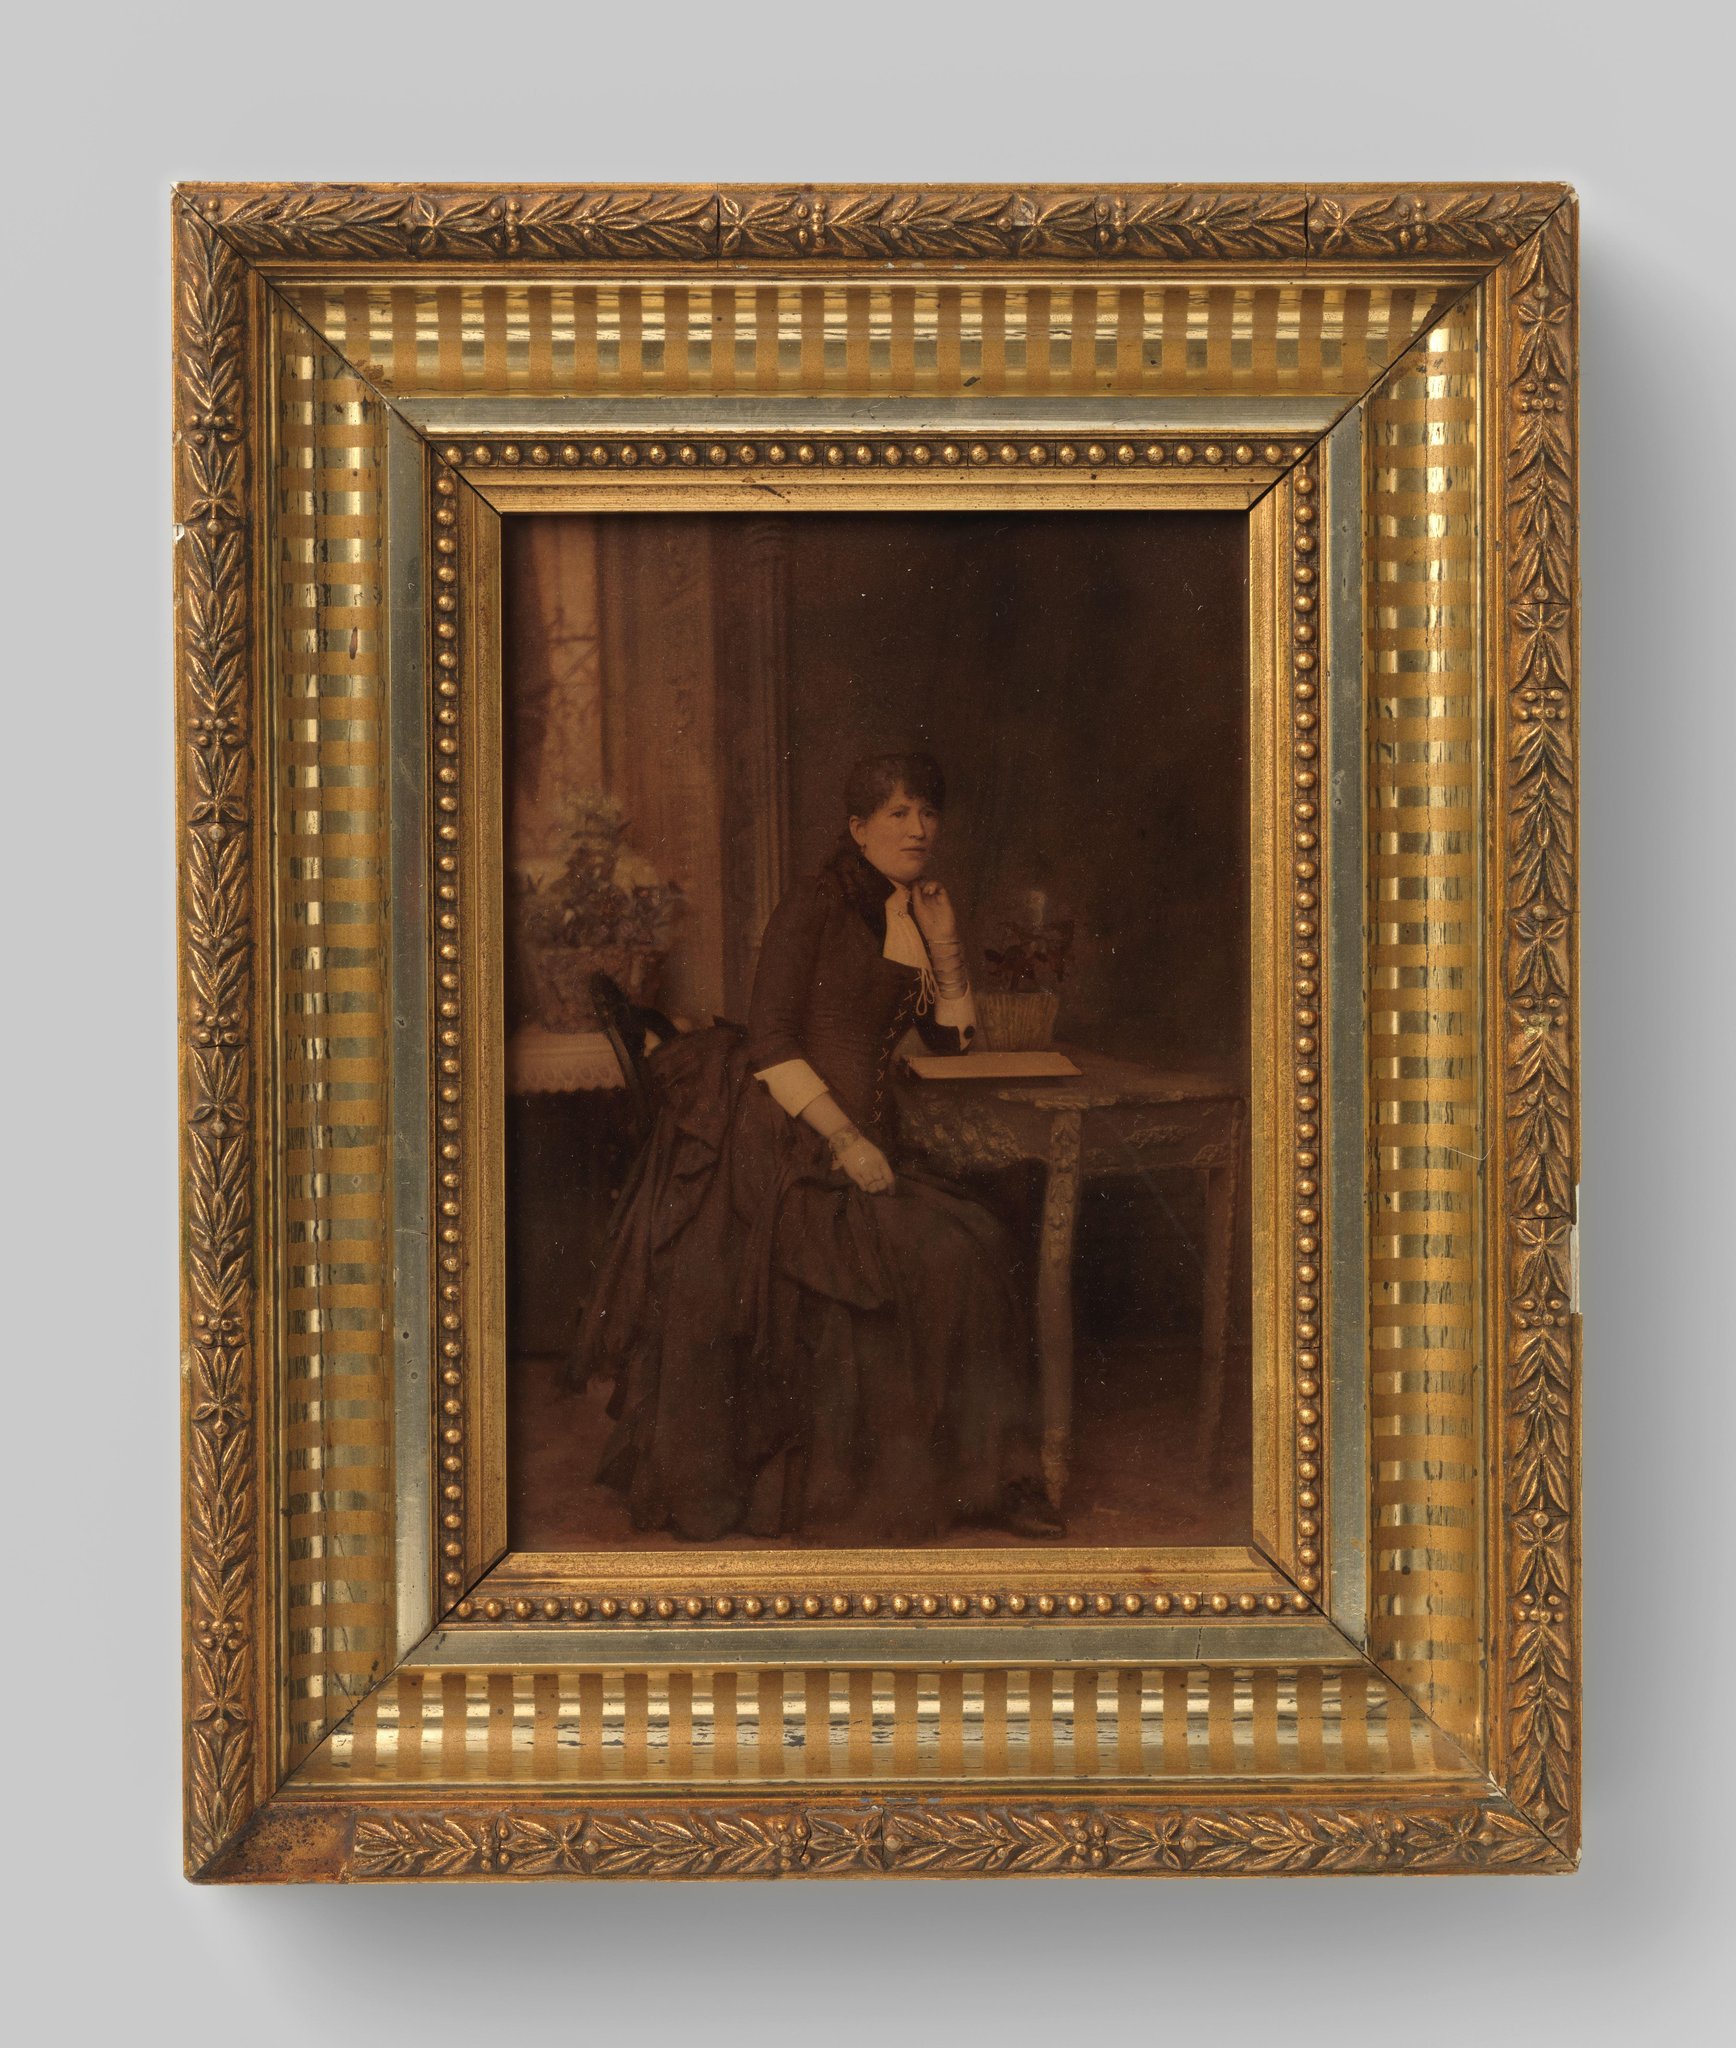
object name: photograph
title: Portret van een onbekende vrouw, zittend aan tafel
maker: Anonymous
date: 1880-1900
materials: cardboard, glass, metal, wood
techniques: albumen print, gilding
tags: sitting figure, anonymous historical person portrayed - bb - woman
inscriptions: inscription: ‘Rap 7,-’, inscription: ‘Echtpaar Engel.Bruyn/ (den Helder)/ gekregen dr. van de Stadt/ Joseph Israëlplein 18 den Haag/ (tel. 248783) juni 1972’